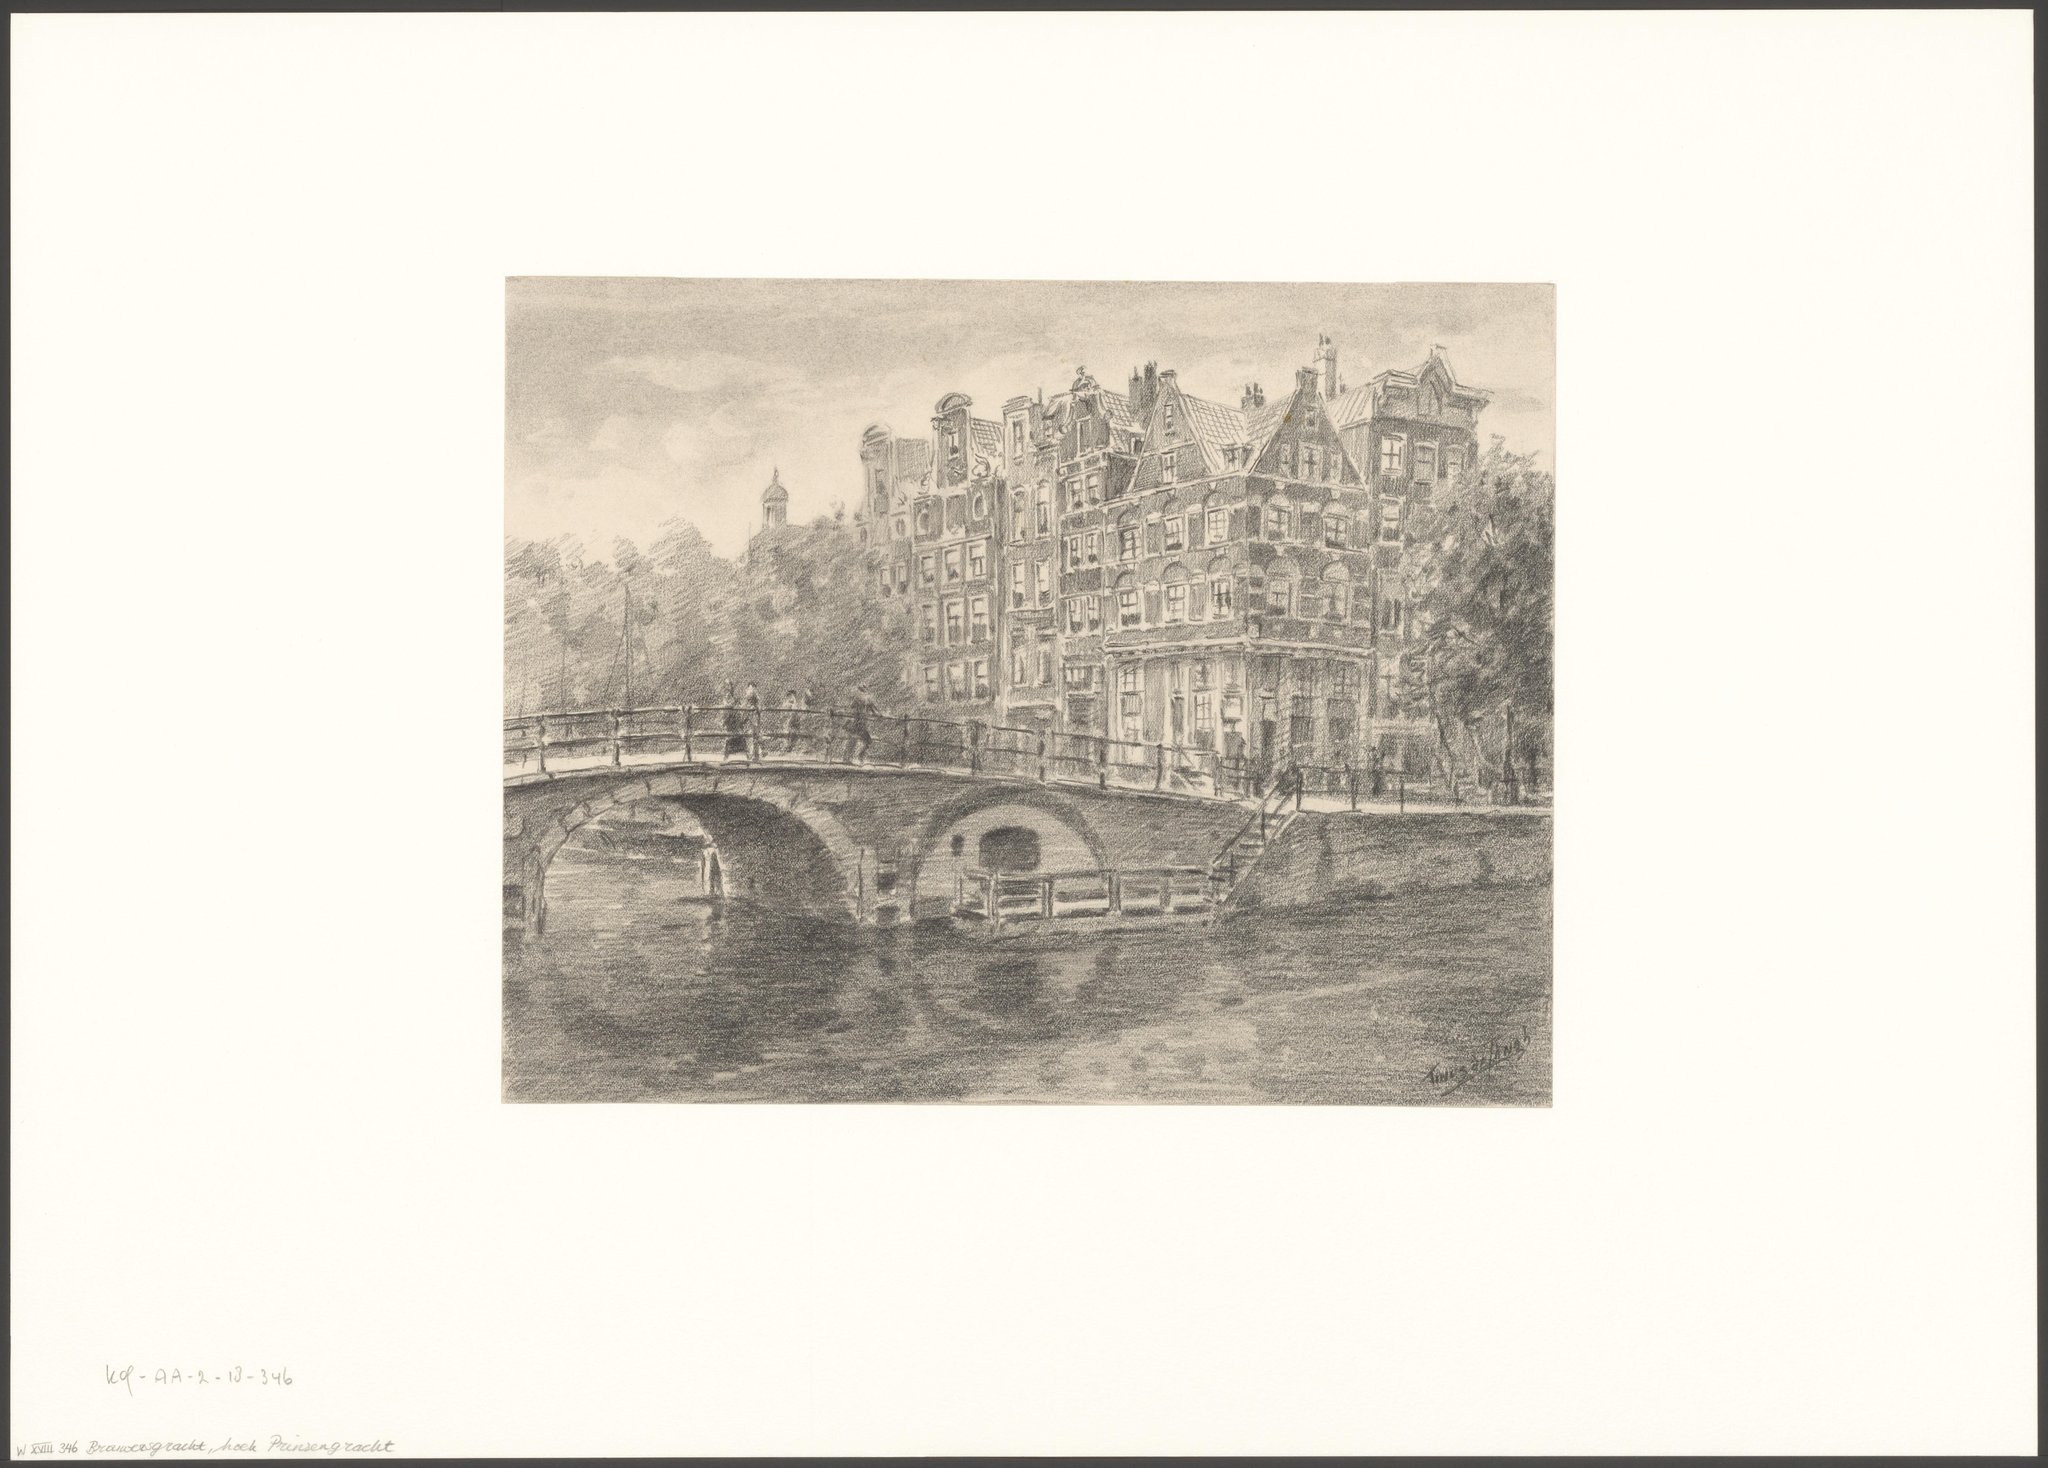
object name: drawing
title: Gezicht op de Brouwersgracht, hoek Prinsengracht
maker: tinus de jongh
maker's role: print maker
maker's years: 1885-1942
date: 1895-1942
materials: chalk, paper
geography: amsterdam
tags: city-view in general; 'veduta', canal, bridge in city across river, canal, etc.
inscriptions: signature: ‘TinusdeJongh’, collector's mark: Lugt 800a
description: Tekening binnen de Atlas Van Eck ingedeeld op wijknummer 18.